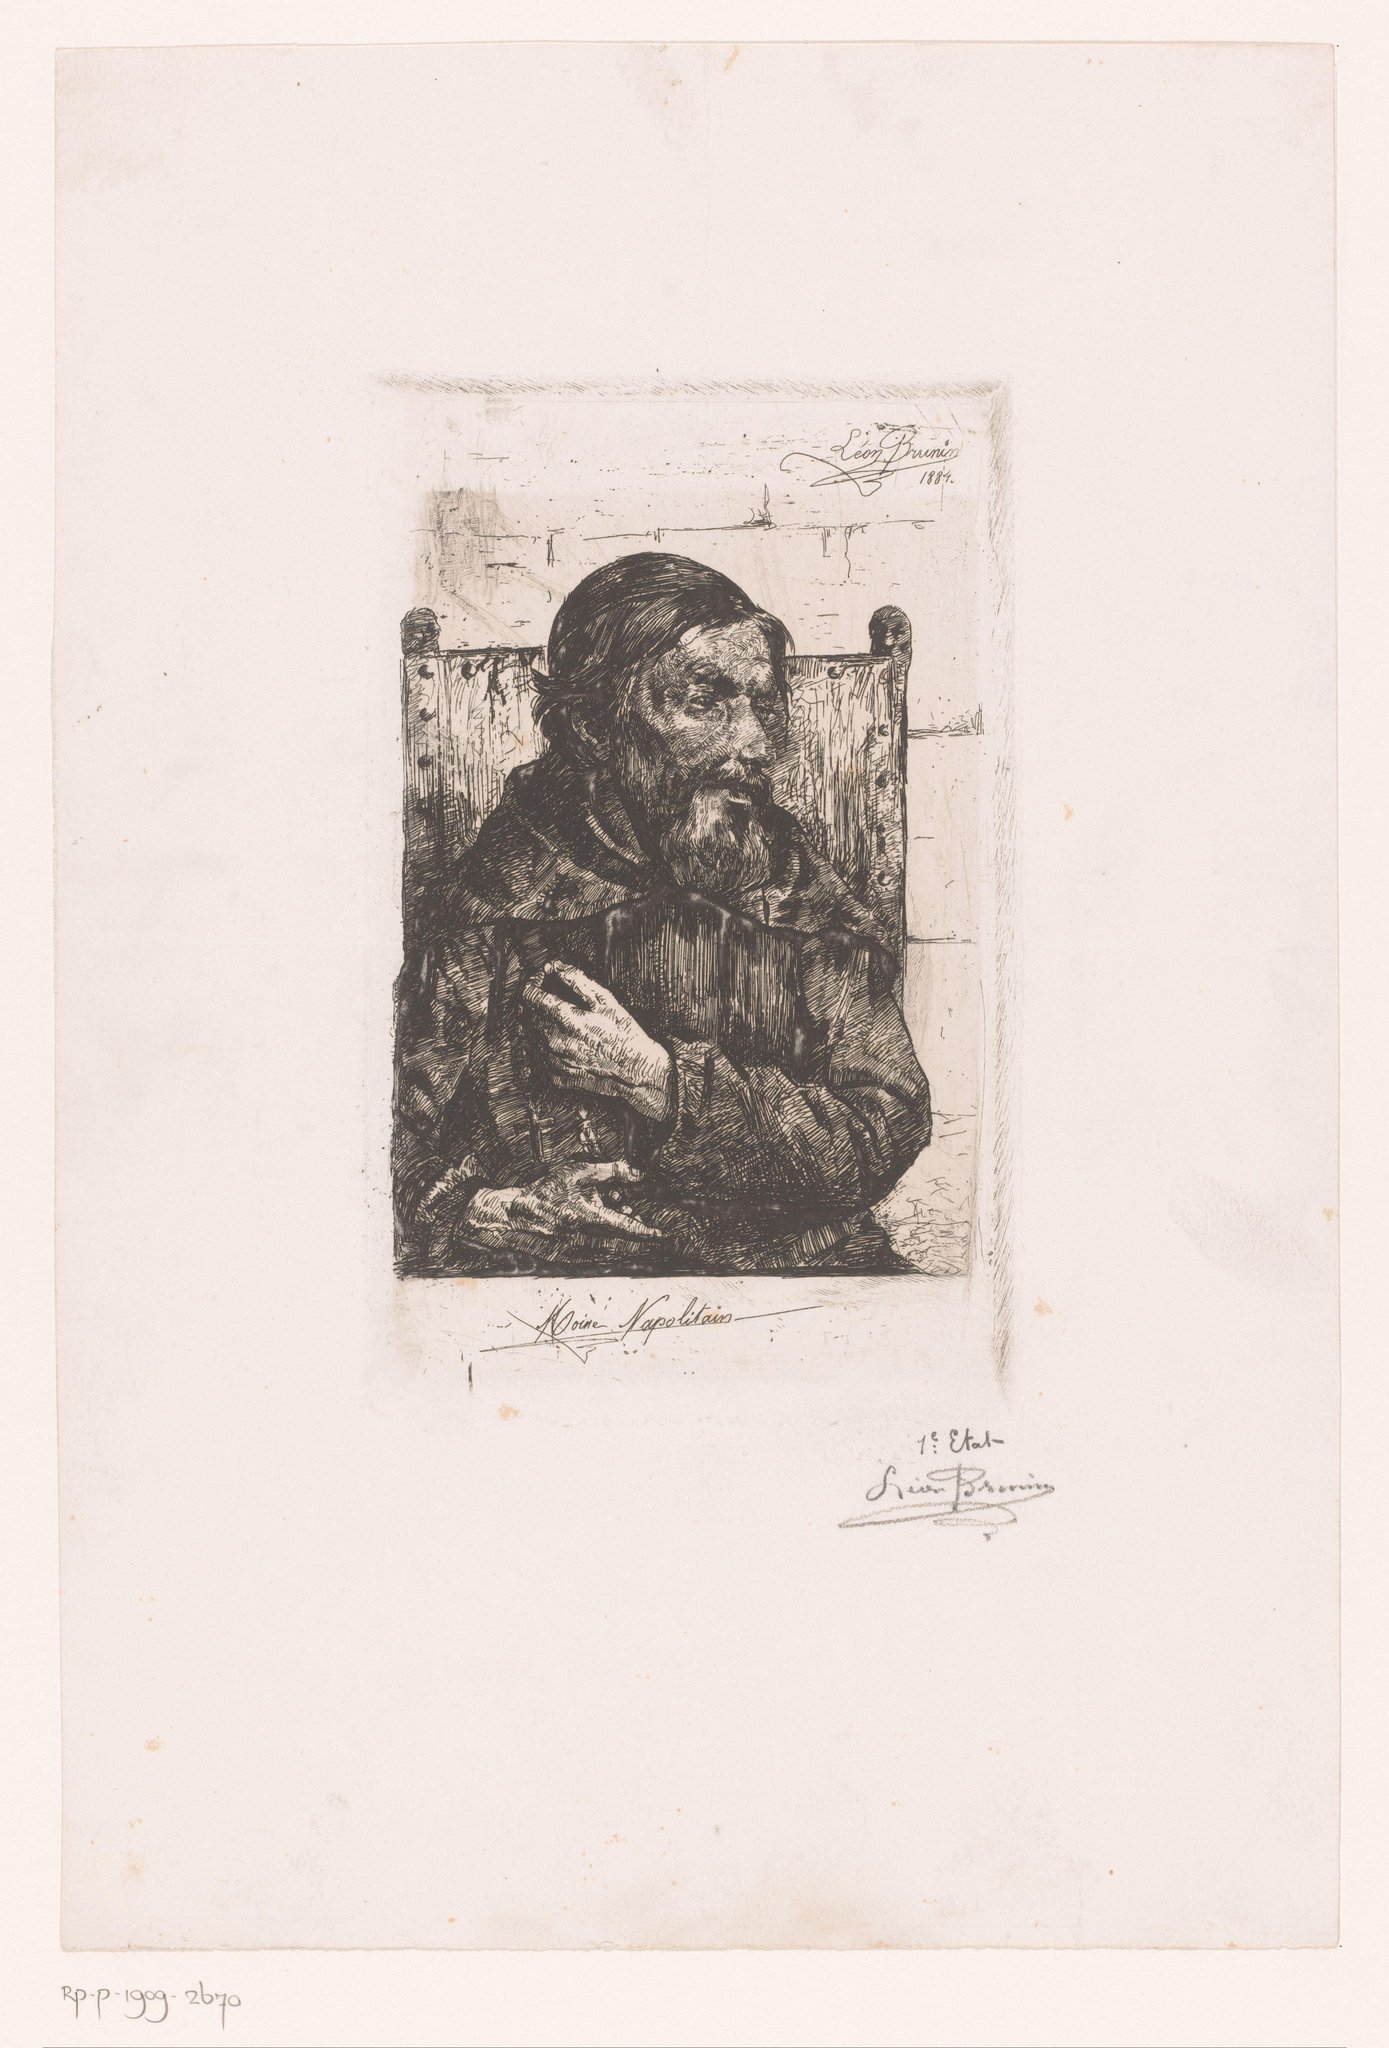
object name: print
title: Napolitaanse monnik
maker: léon brunin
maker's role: print maker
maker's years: 1861-1949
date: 1884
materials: paper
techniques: etching, intaglio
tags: monk(s), friar(s)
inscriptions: collector's mark: Lugt 2228, annotation: ‘1e Etat’